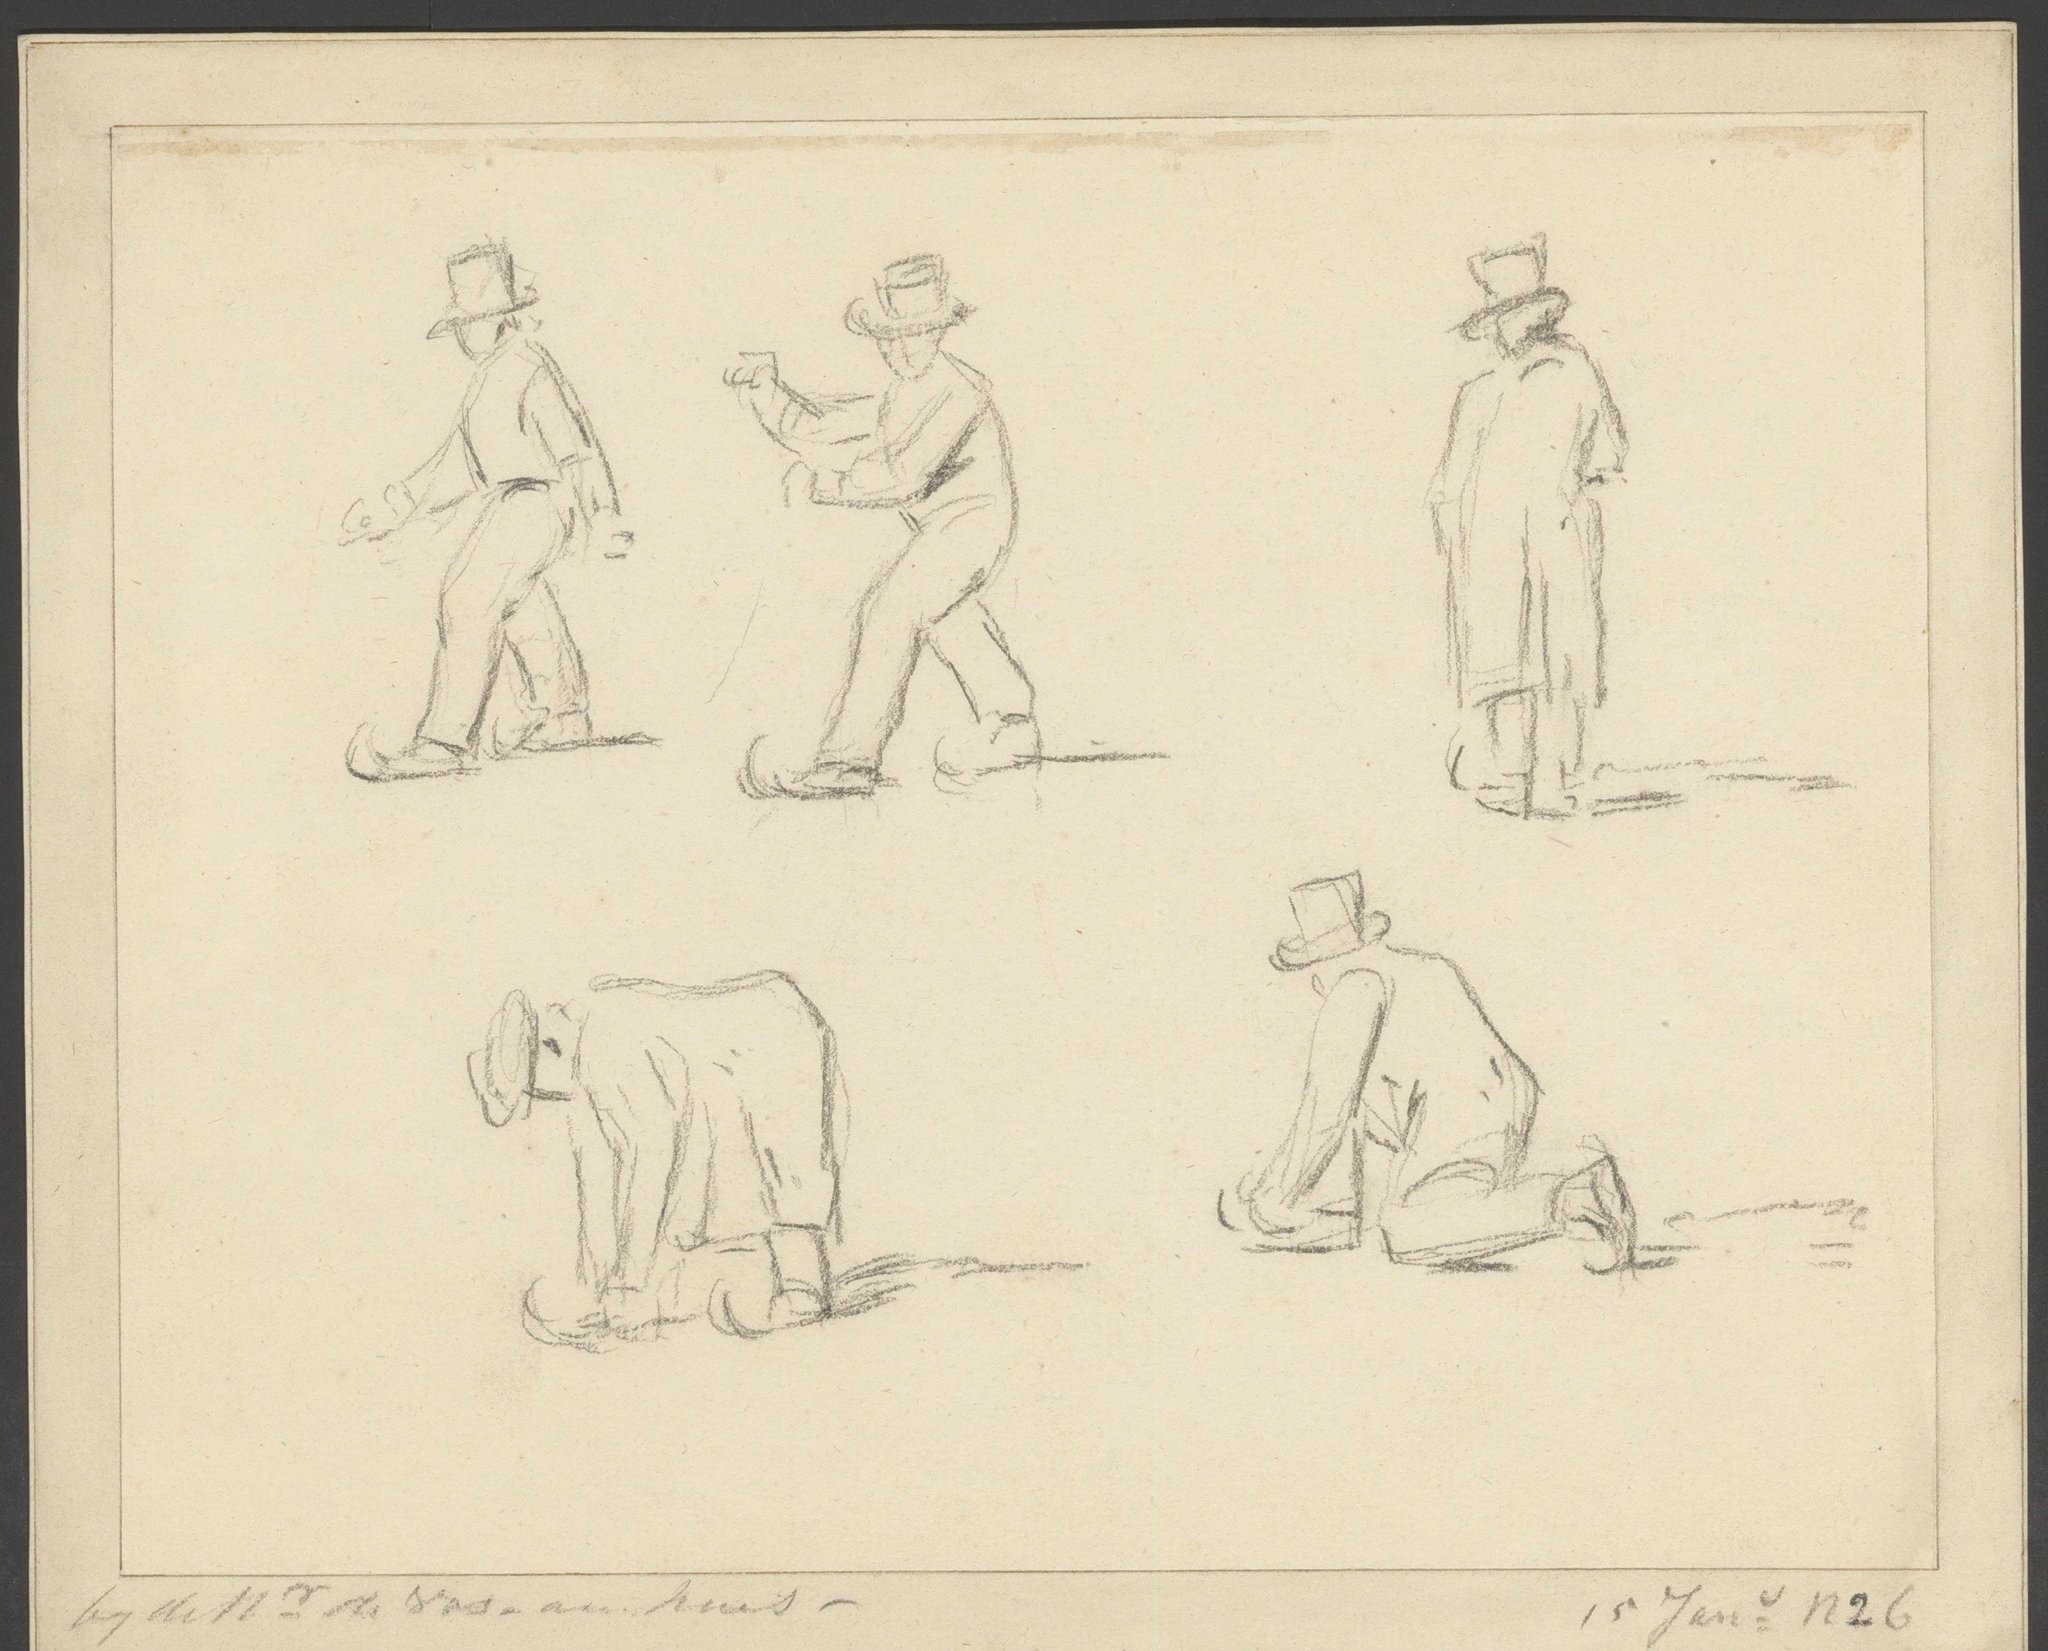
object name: drawing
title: Vijf mannen met hoge hoeden in verschillende houdingen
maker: jean bernard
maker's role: draughtsman, print maker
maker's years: 1765-1833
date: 1826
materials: chalk, paper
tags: dancing, crawling, going on all fours, walking, head-gear: top hat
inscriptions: collector's mark: Lugt 1641, stamp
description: Onderwerpsrubrieken binnen de Atlas Zeden en Gewoonten: Schoone kunsten, Schilderkunst, Tekeningen.